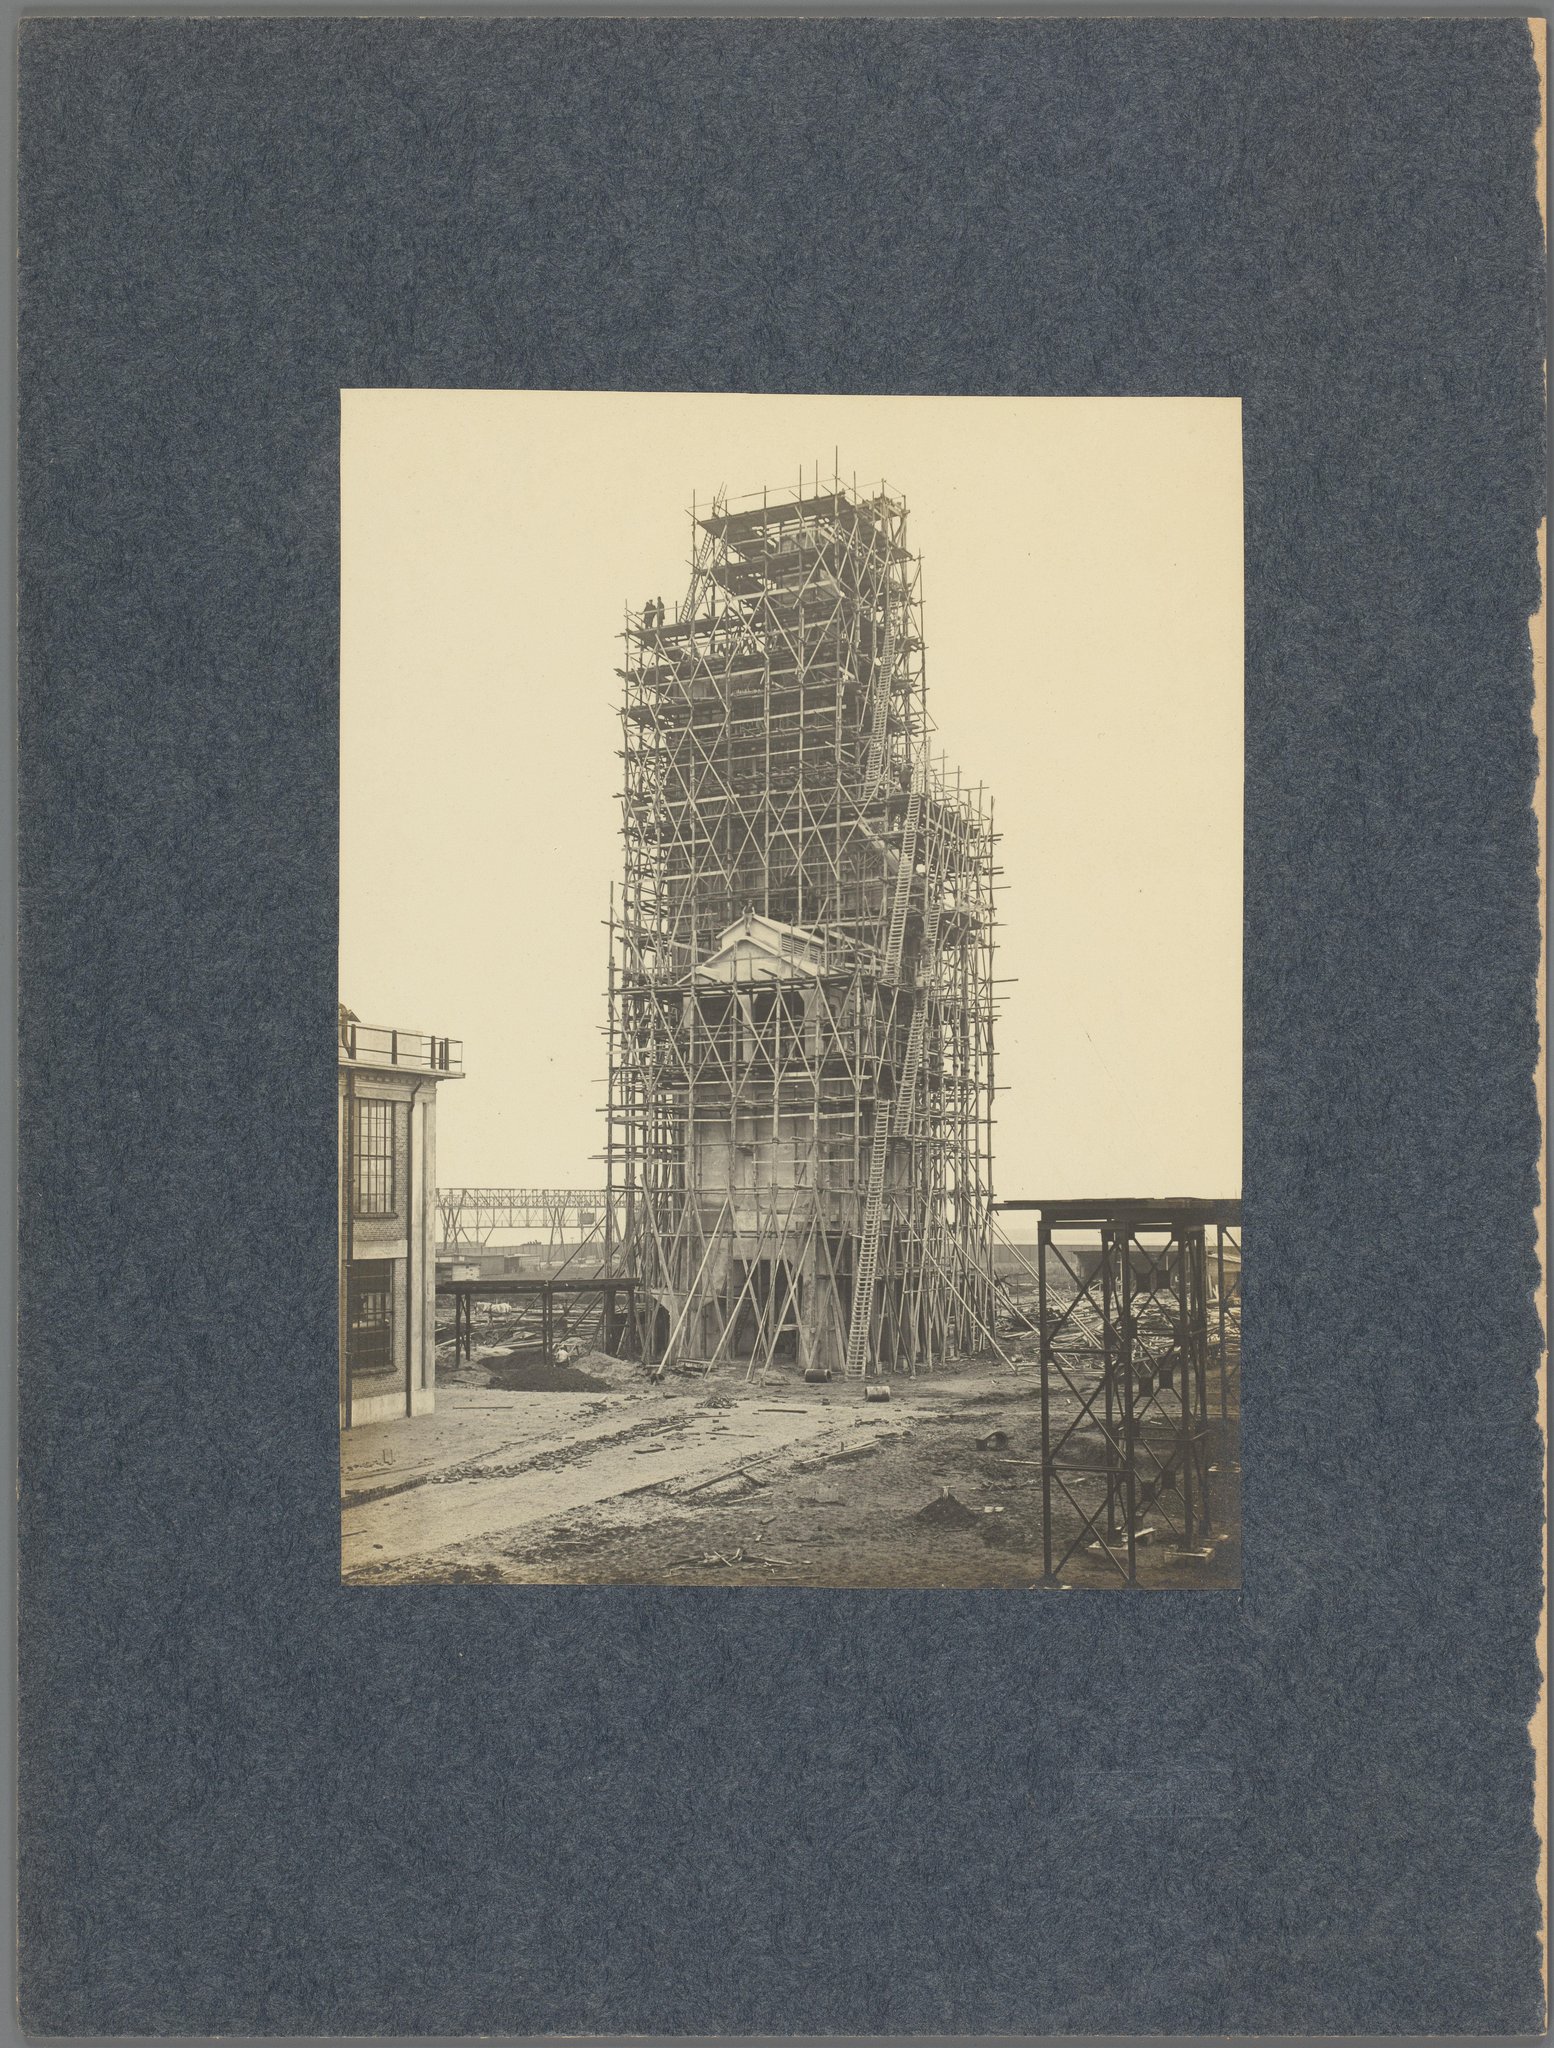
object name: photograph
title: Cokesoven in de steigers in de Keilehaven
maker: willem sr. bleuzé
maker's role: fotograaf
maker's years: 1873-1948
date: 1913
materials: paper, cardboard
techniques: gelatin silver print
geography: rotterdam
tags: factory-building, building-site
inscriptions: inscription: ‘29/1 '13’, address: ‘W. BLEUZÉ/ ROTTERDAM/ JONKER FRANSSTRAAT 66’